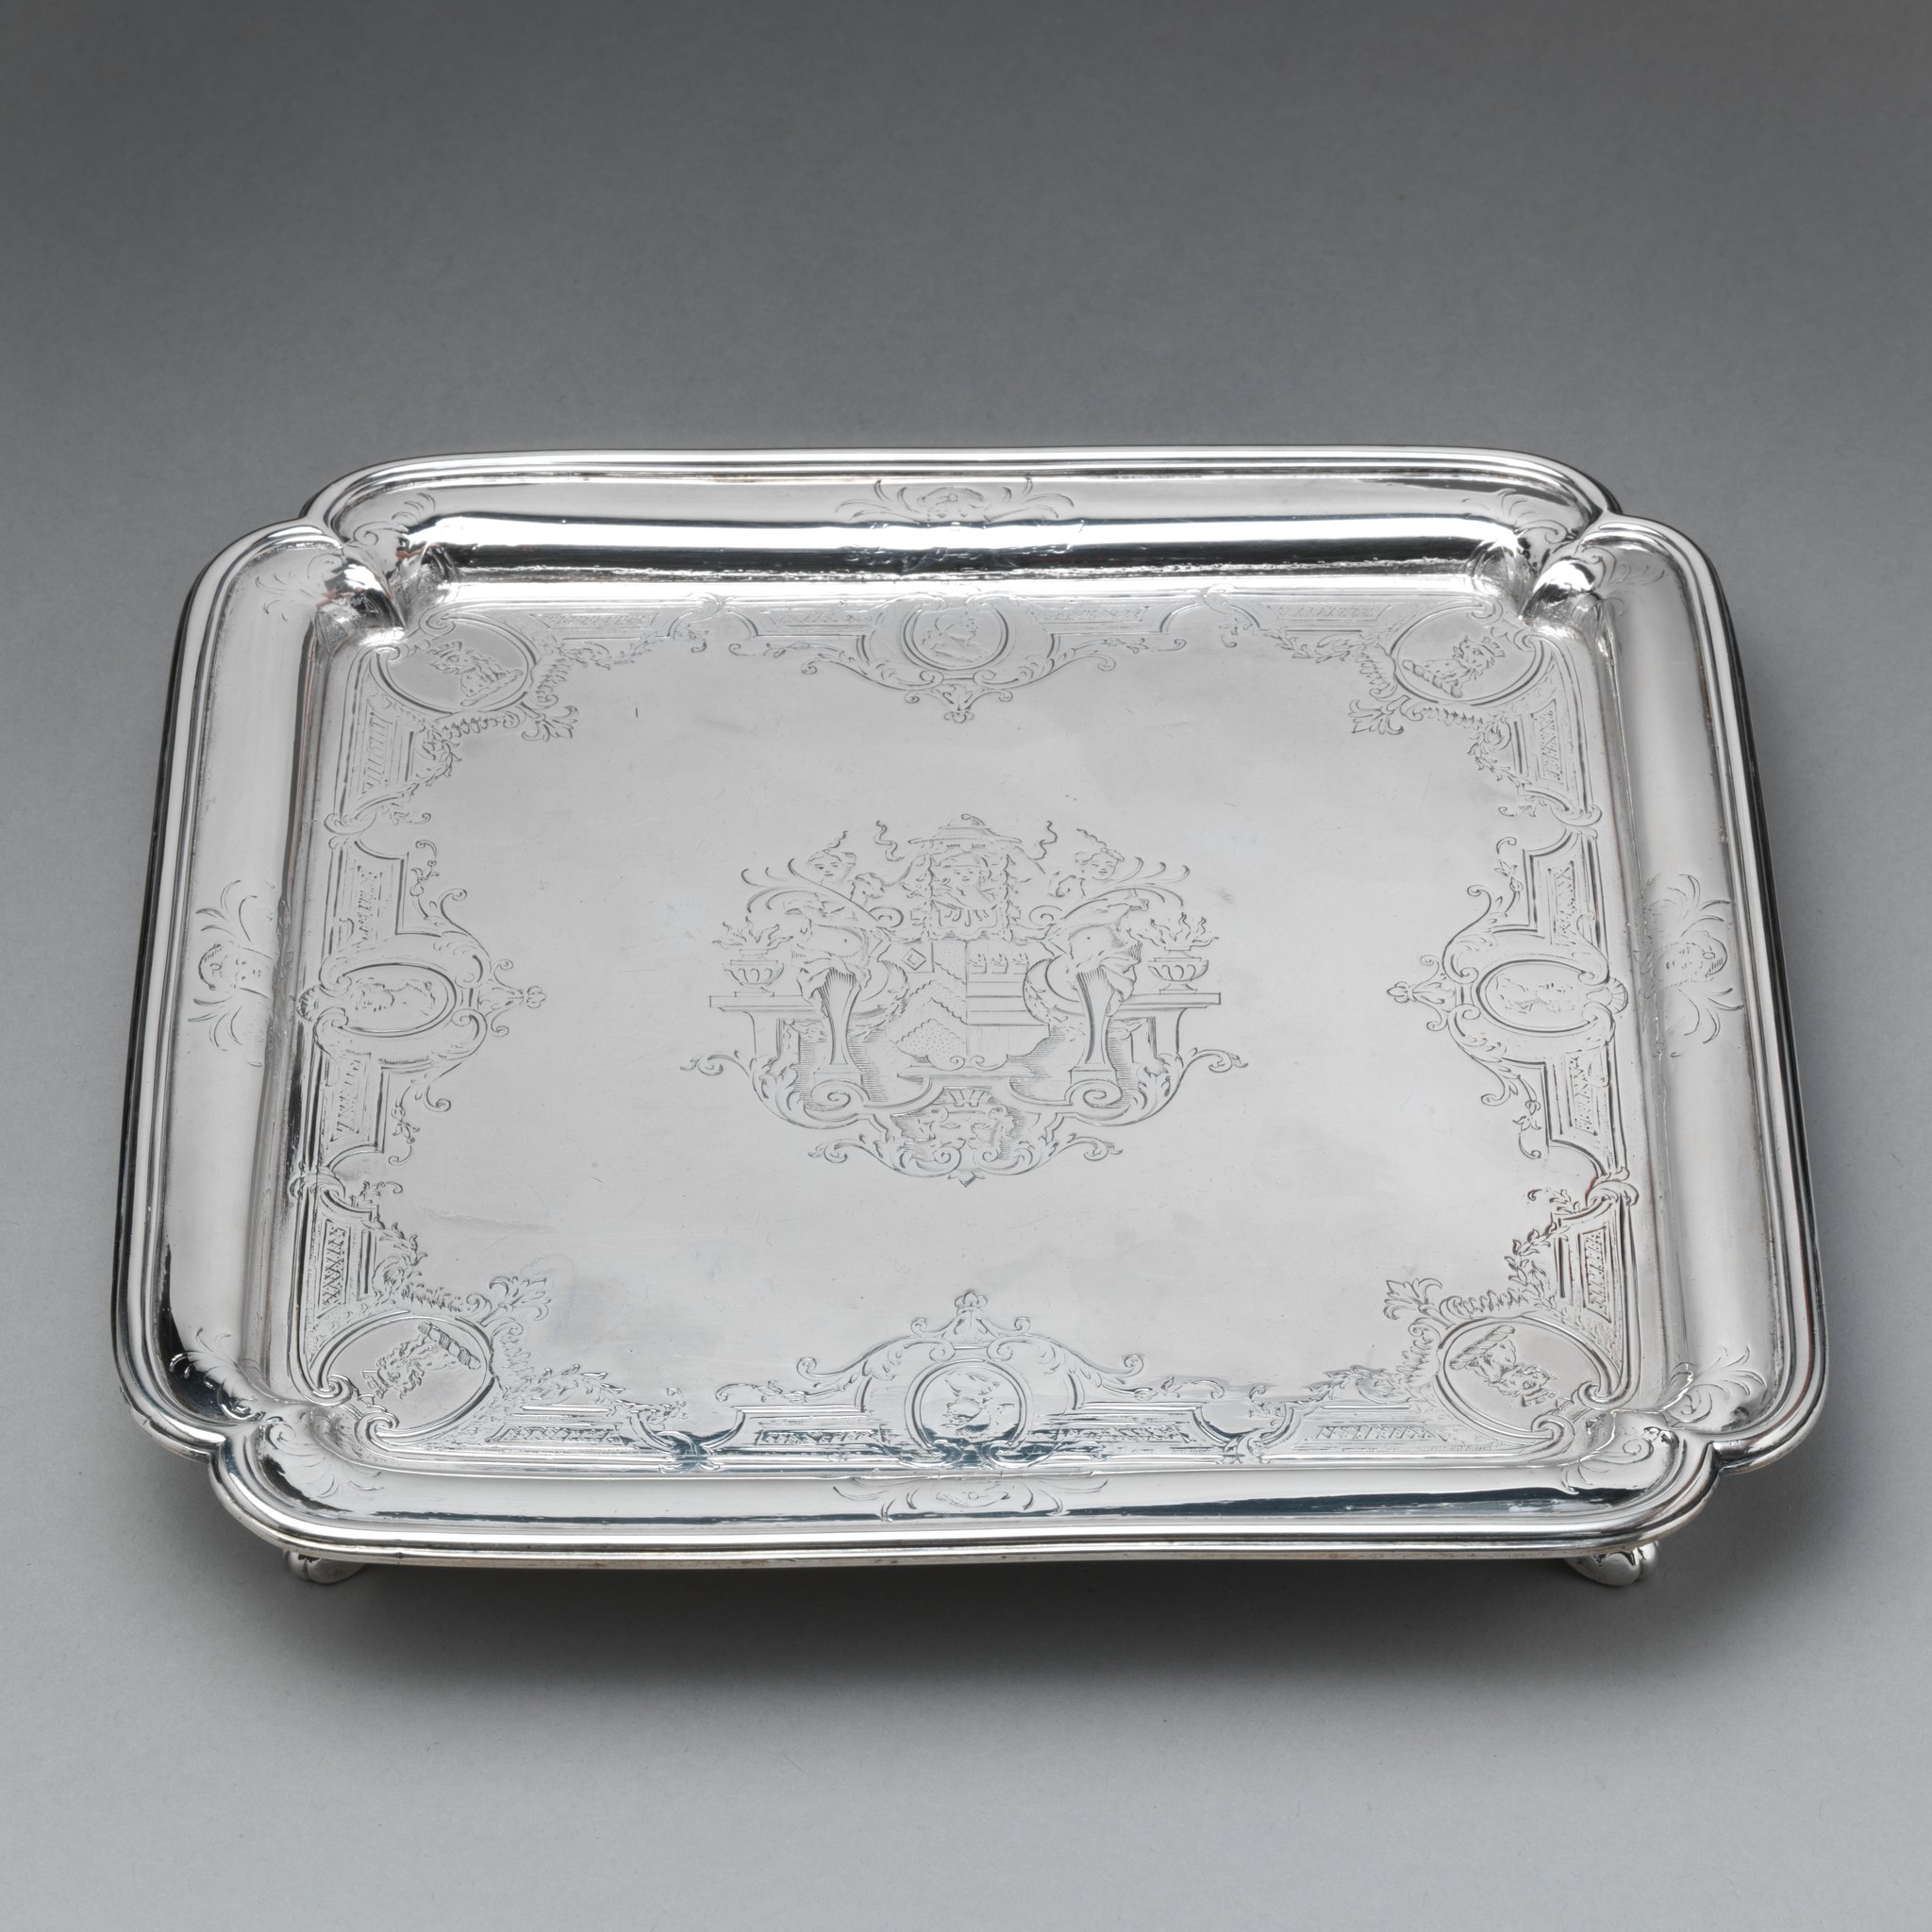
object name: salver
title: Salver (one of a pair)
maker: paul de lamerie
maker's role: maker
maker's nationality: british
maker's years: 1688-1751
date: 1730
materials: silver